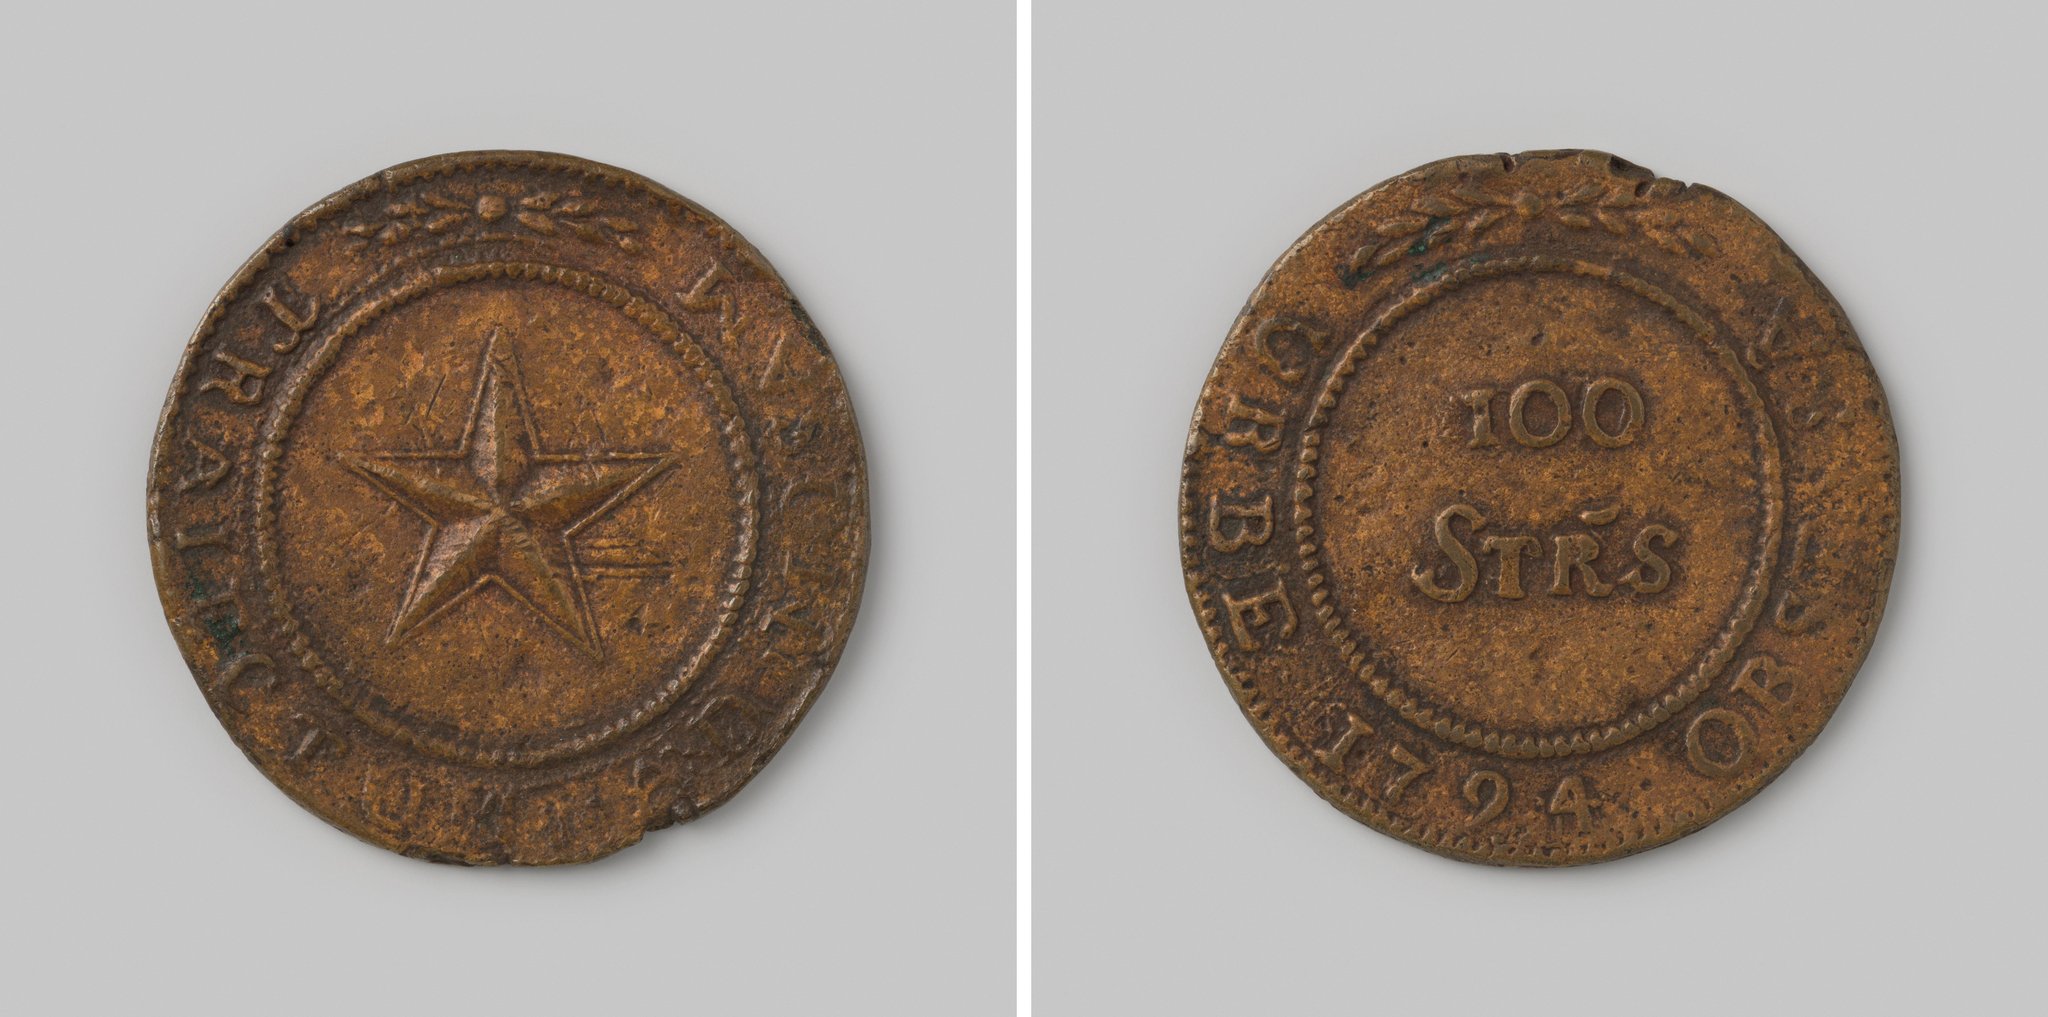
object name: coin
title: Stad Maastricht, noodmunt van 100 stuiver, 1794. Afgietsel in koper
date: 1794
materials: copper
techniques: striking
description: Koperen afgietsel van zilveren noodmunt. Voorzijde: ster van Maastricht, daarboven in cartouche jaartal en daaronder in cartouche waarde-aanduiding. Onderaan klein monogram: LE. Keerzijde: glad.